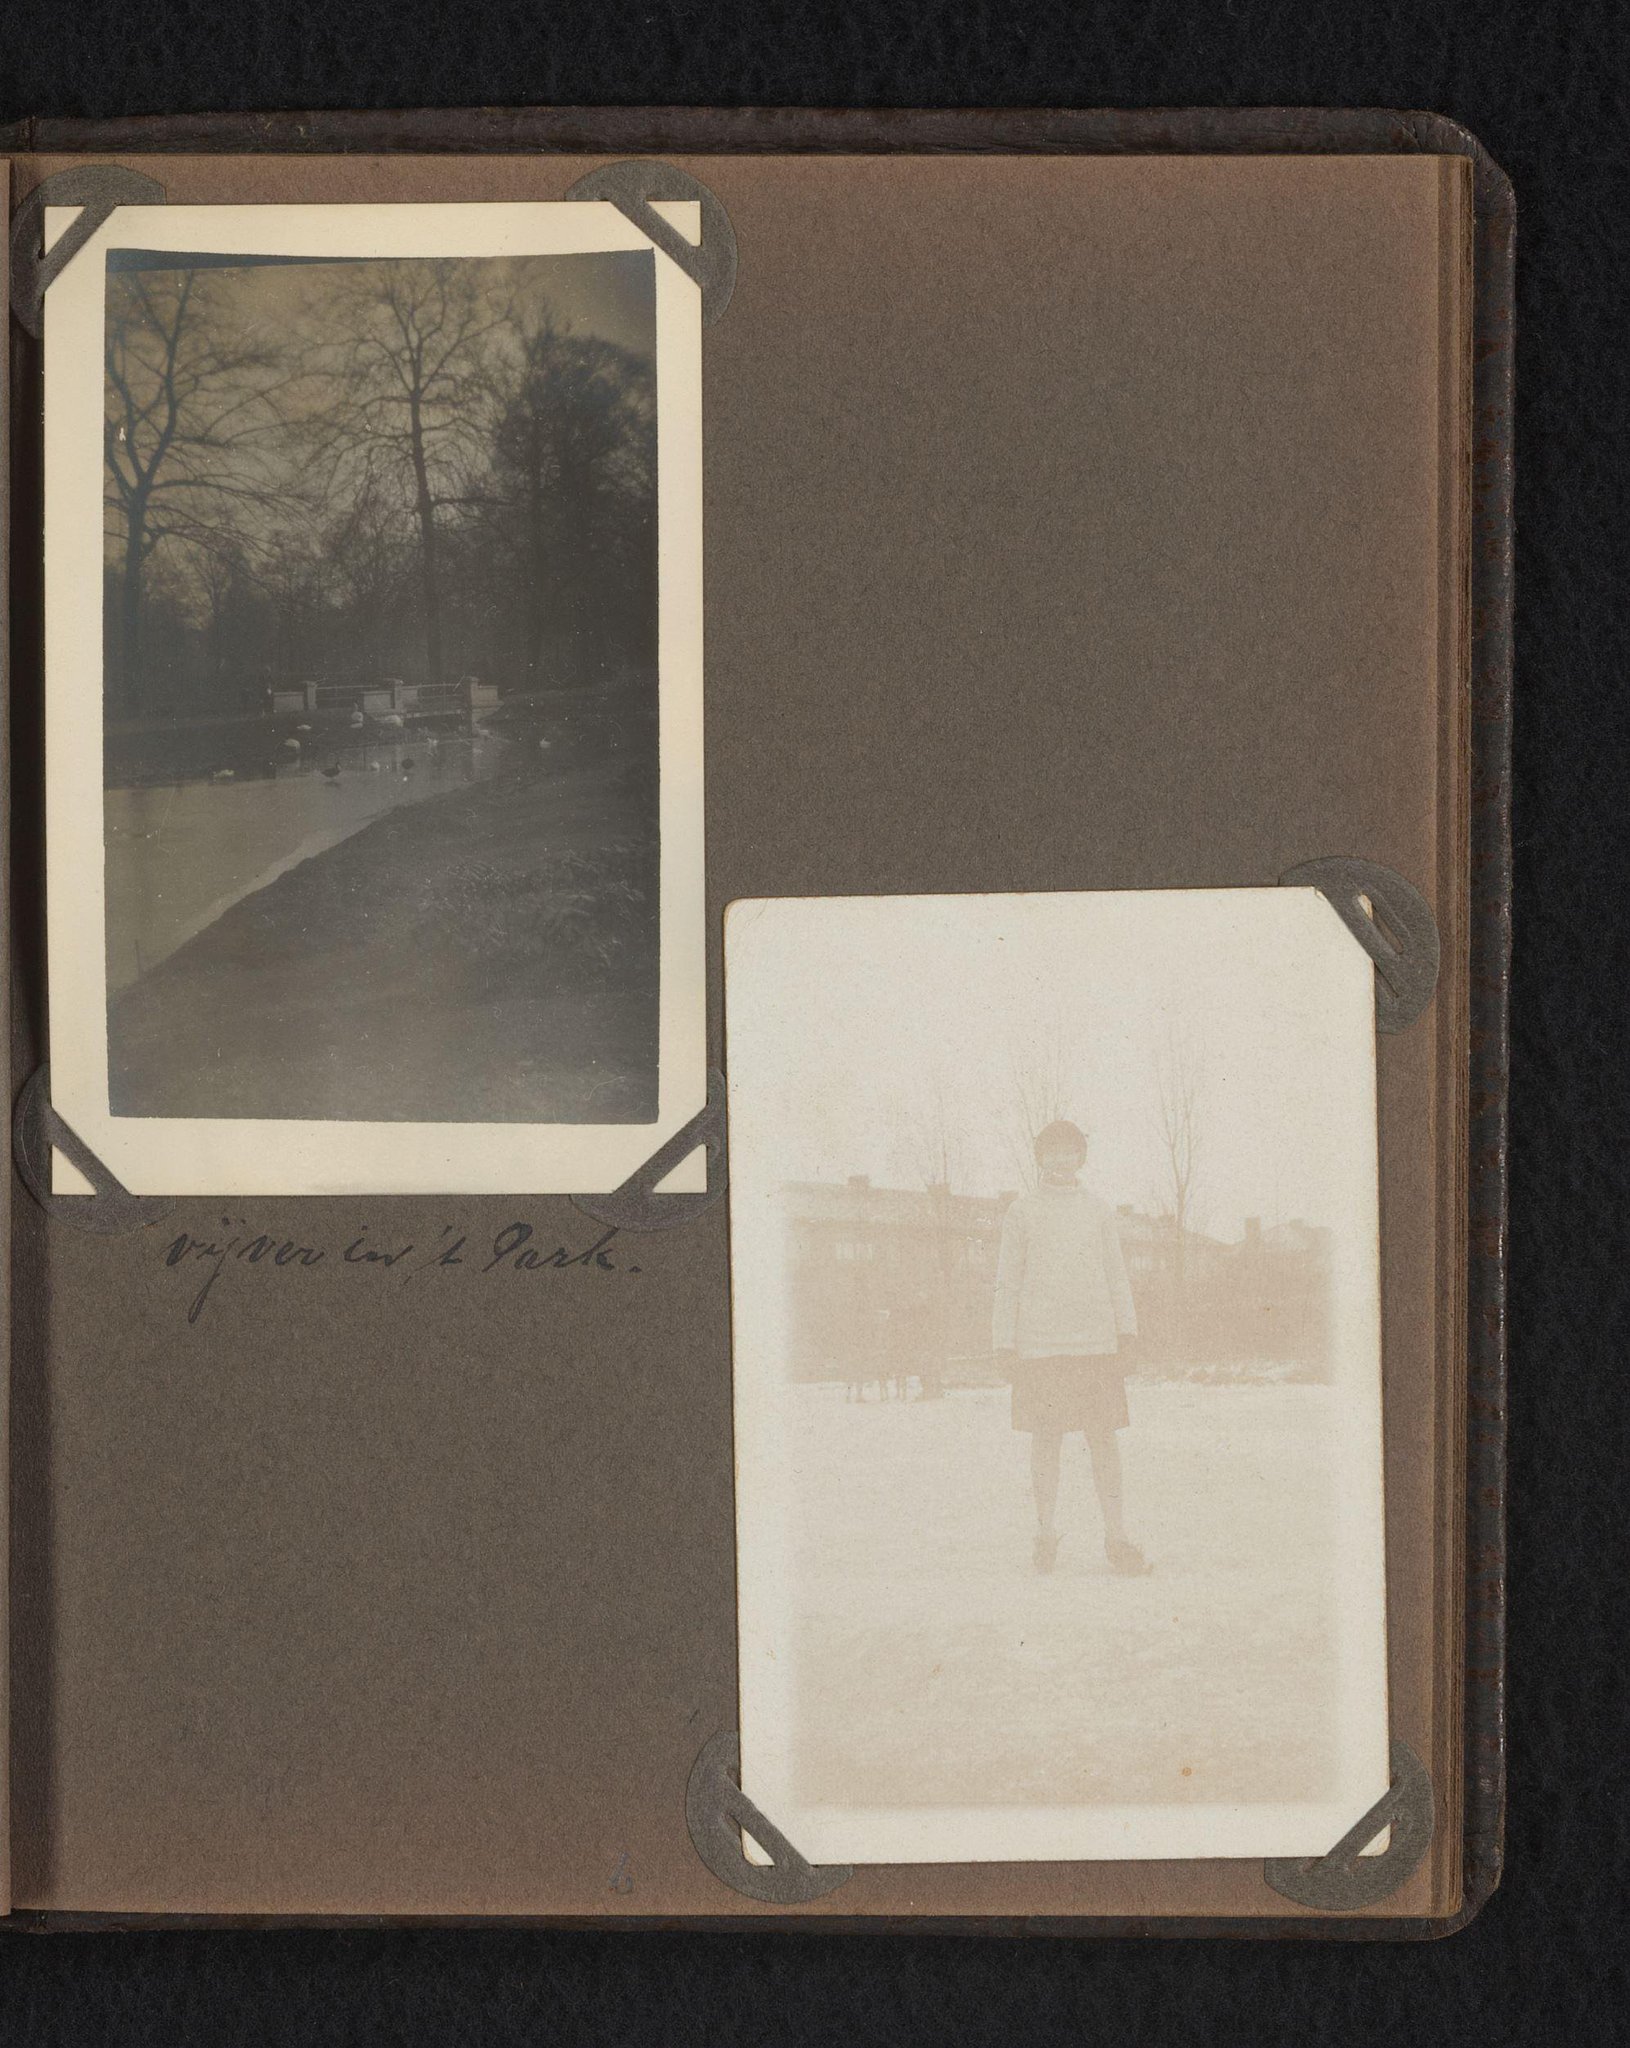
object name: photograph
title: vijver in 't Park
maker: Anonymous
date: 1929-1930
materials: paper, photographic support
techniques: gelatin silver print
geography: rotterdam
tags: skates (winter sports), public gardens, park, rotterdam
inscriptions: inscription: ‘vijver in 't Park’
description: Albumblad met twee foto's. Boven vogels op het ijs van een bevroren vijver in een stadspark, onder een vrouw met schaatsen op het ijs. Onderdeel van het fotoalbum Graf Zeppelin.